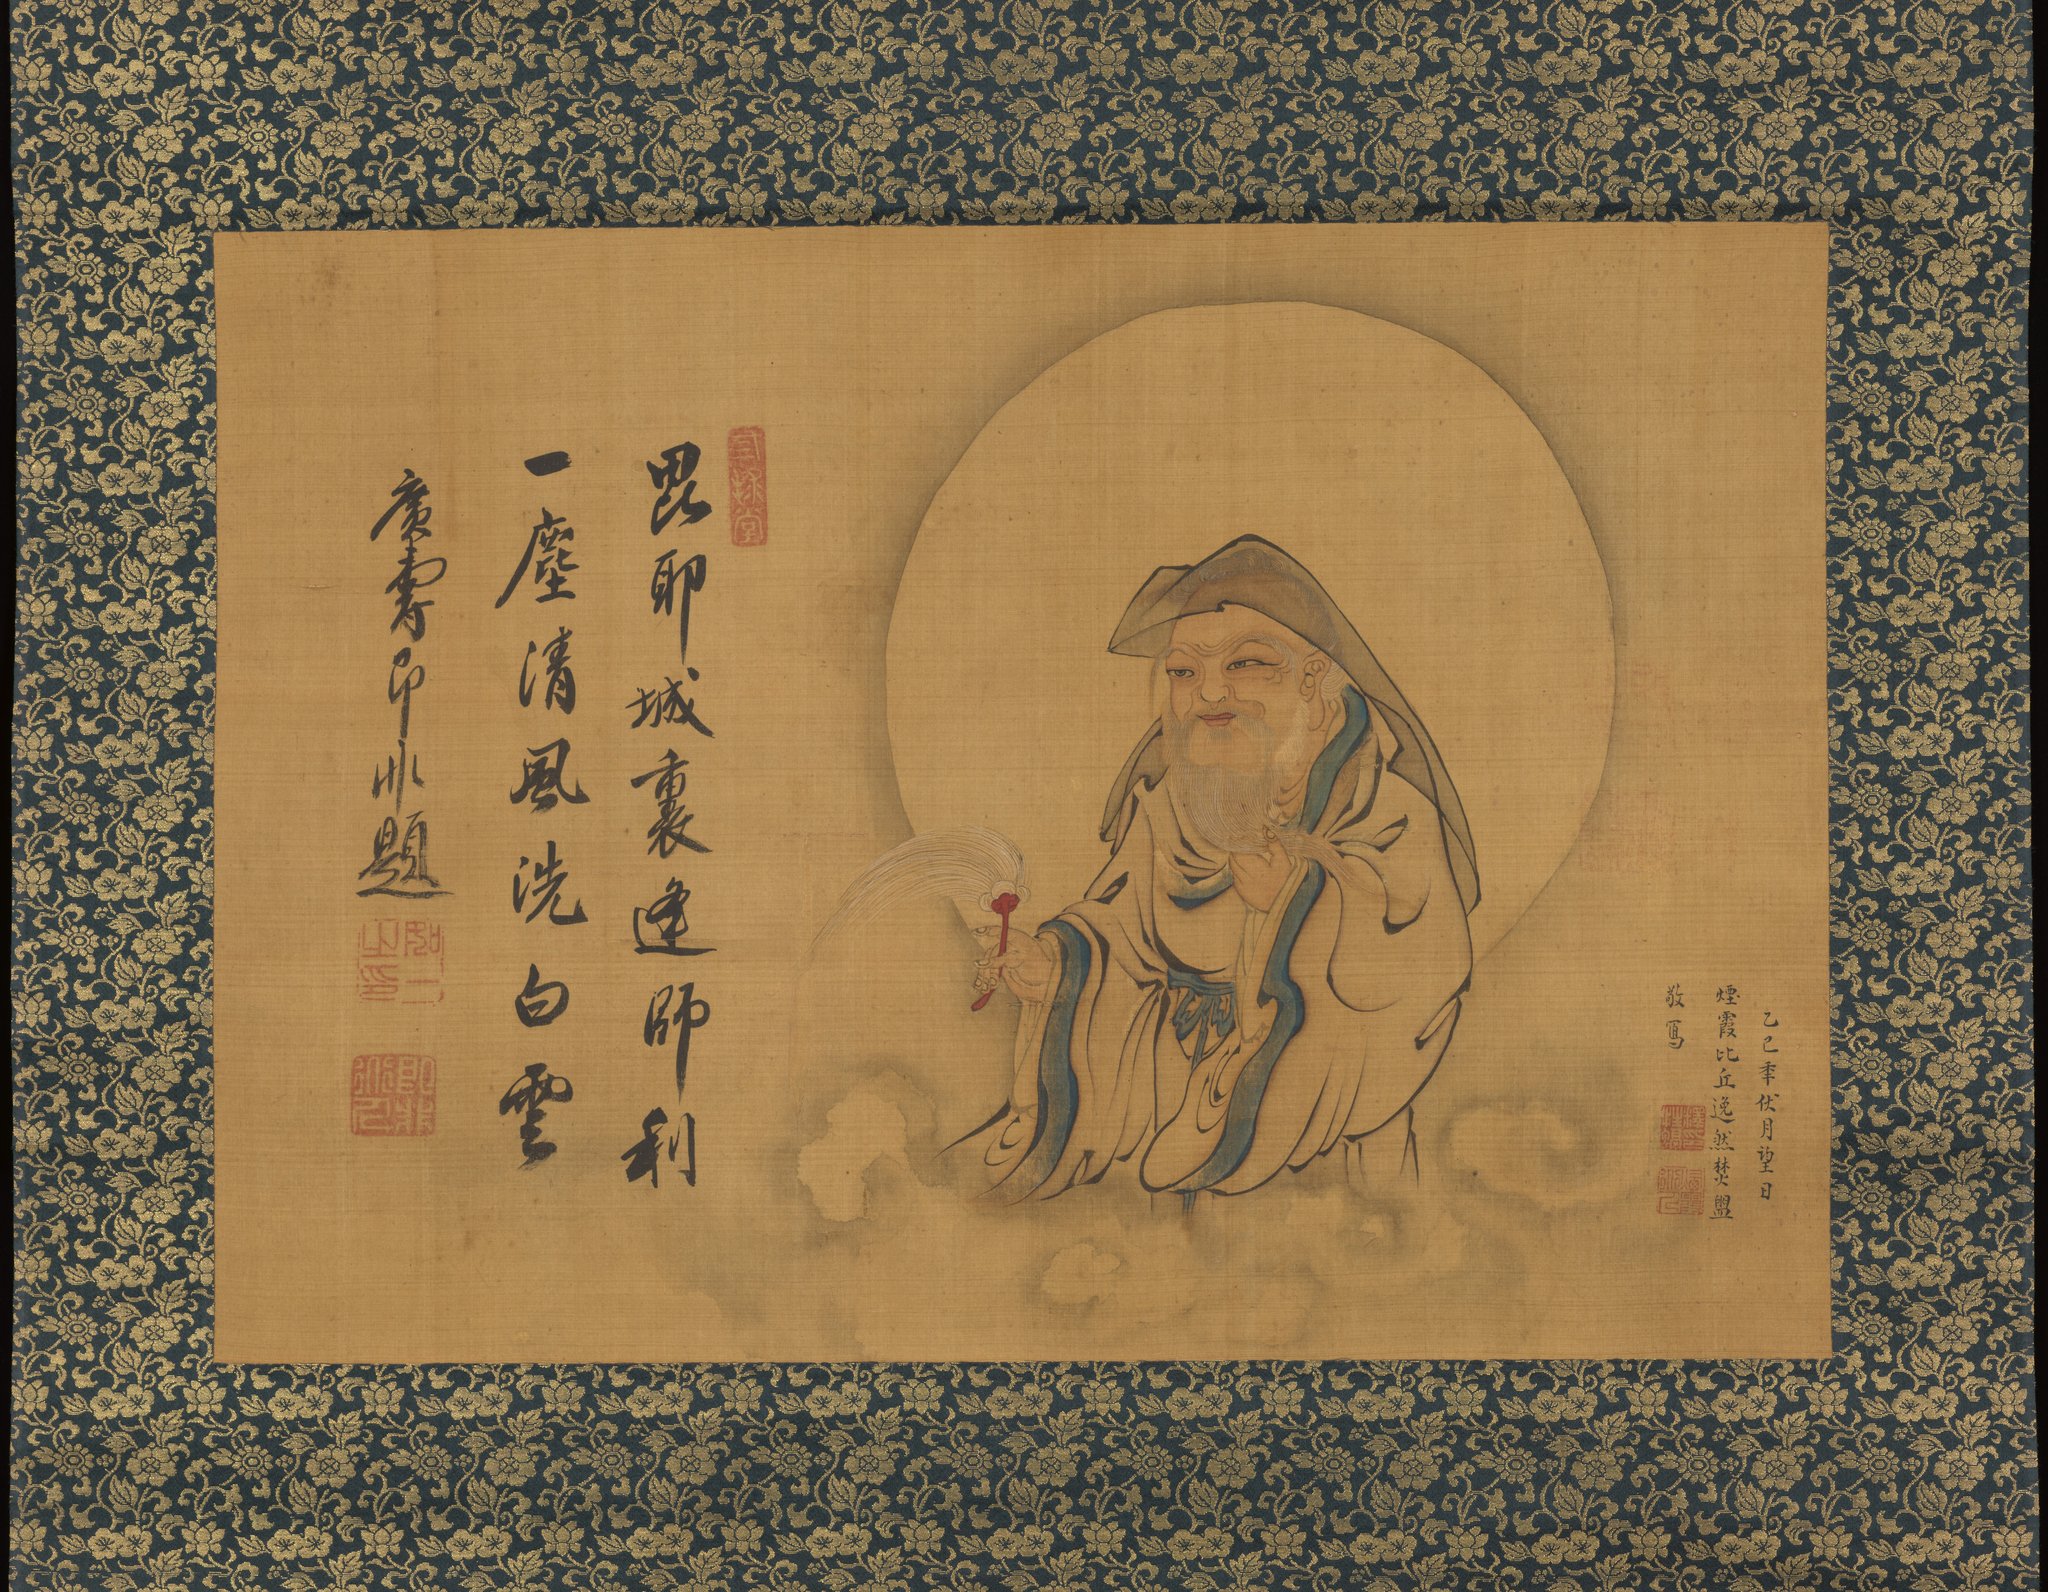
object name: hanging scroll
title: The Lay Buddhist Vimalakirti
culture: japanese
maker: yiran xingrong (itsunen shōyū)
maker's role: artist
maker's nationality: chinese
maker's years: 1601-1668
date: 1665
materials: ink, silk